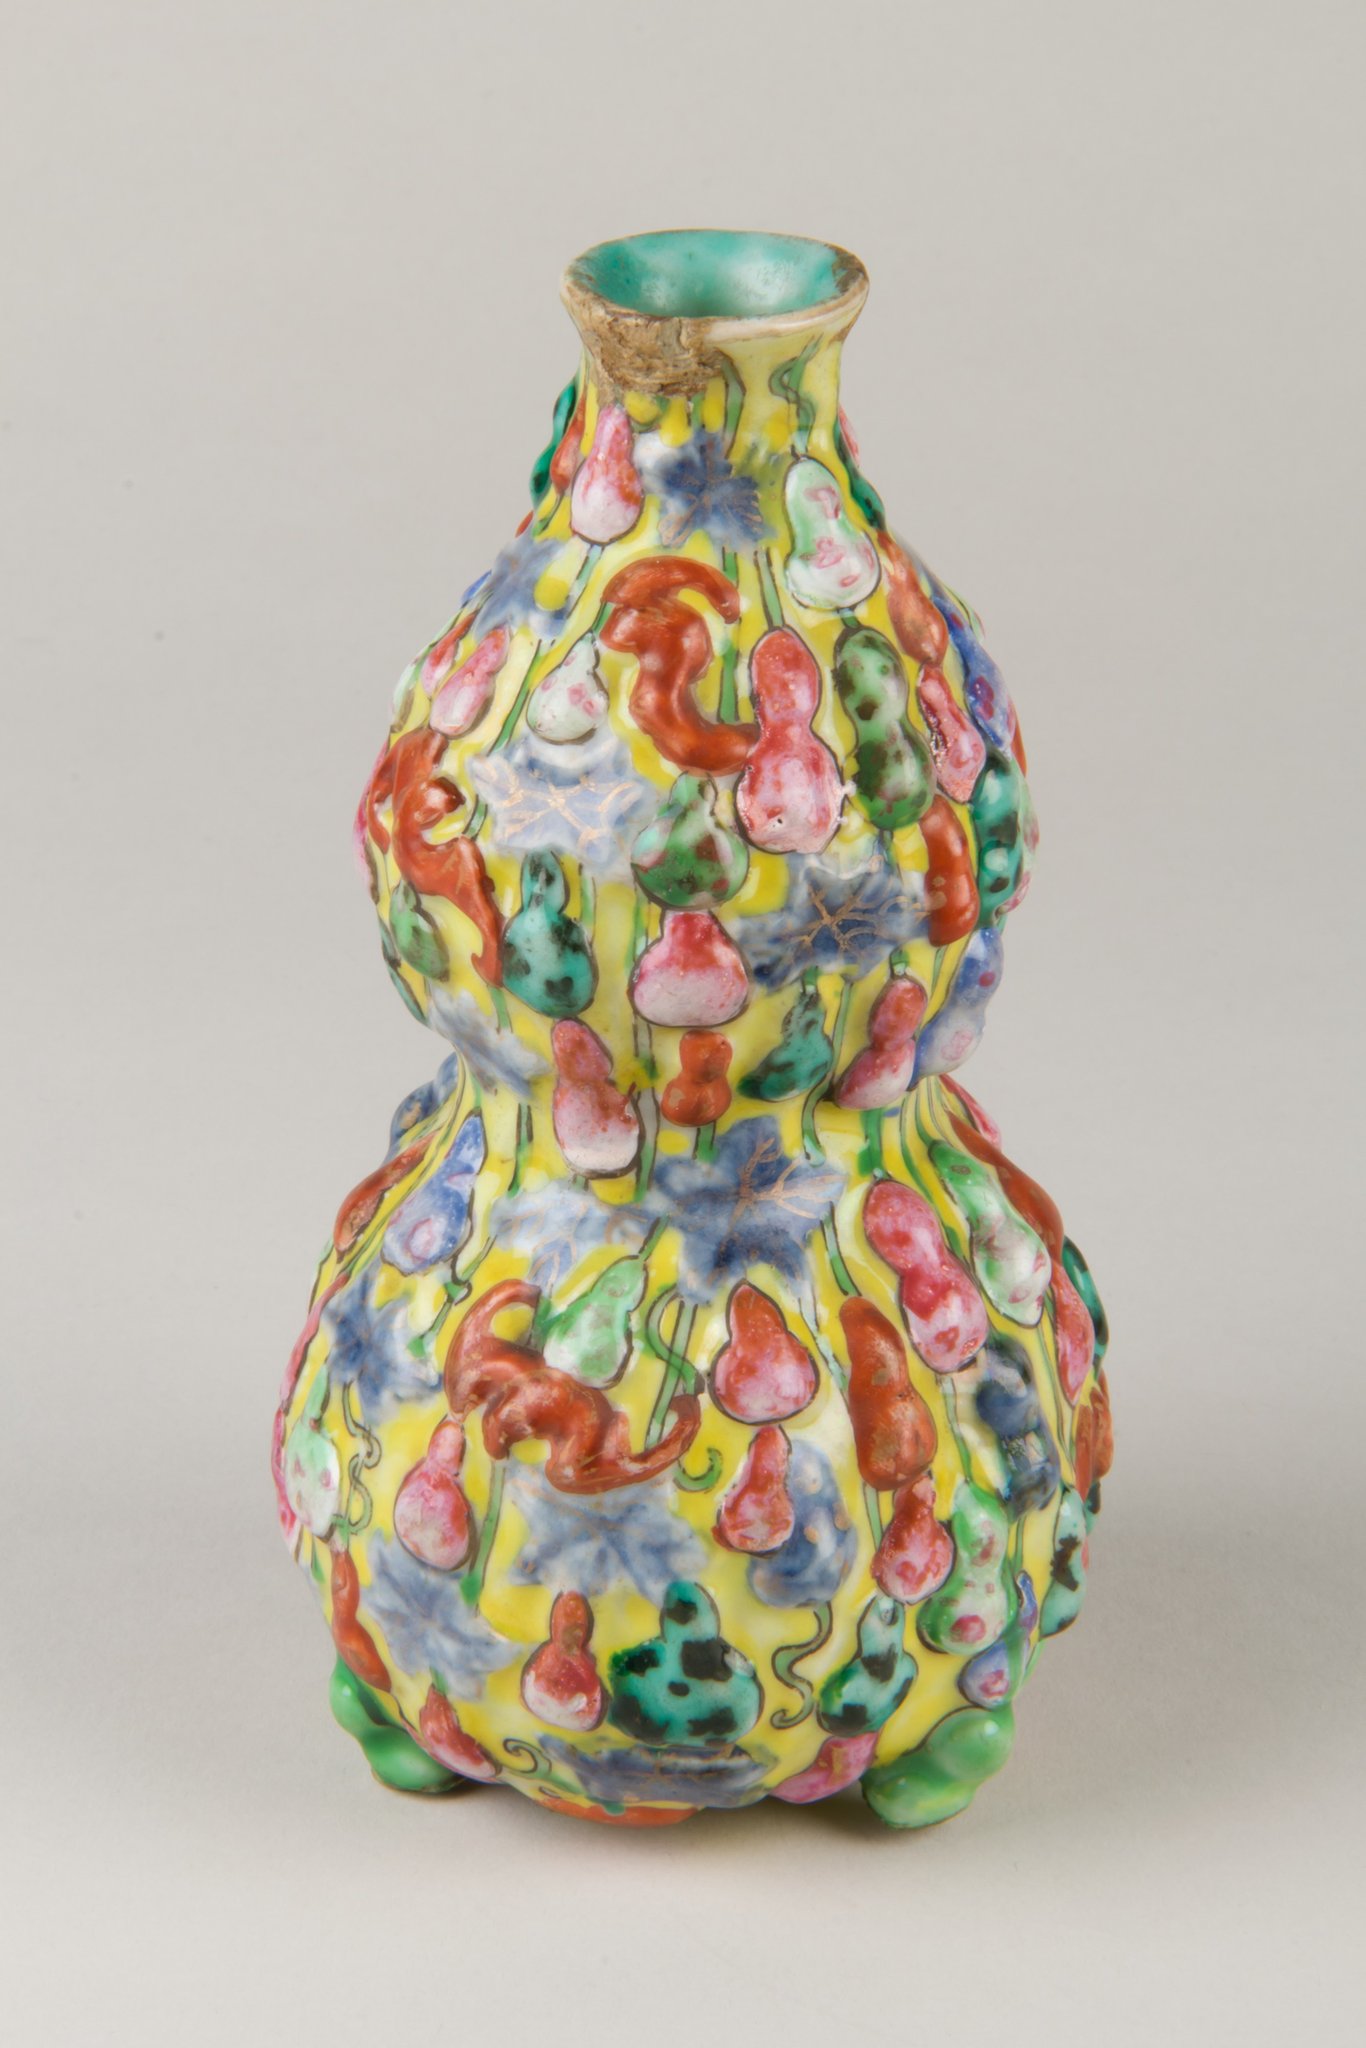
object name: vase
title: Double gourd vase with gourd vines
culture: chinese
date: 1801-1900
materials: enamel, porcelain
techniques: overglaze, painting, polychrome, relief